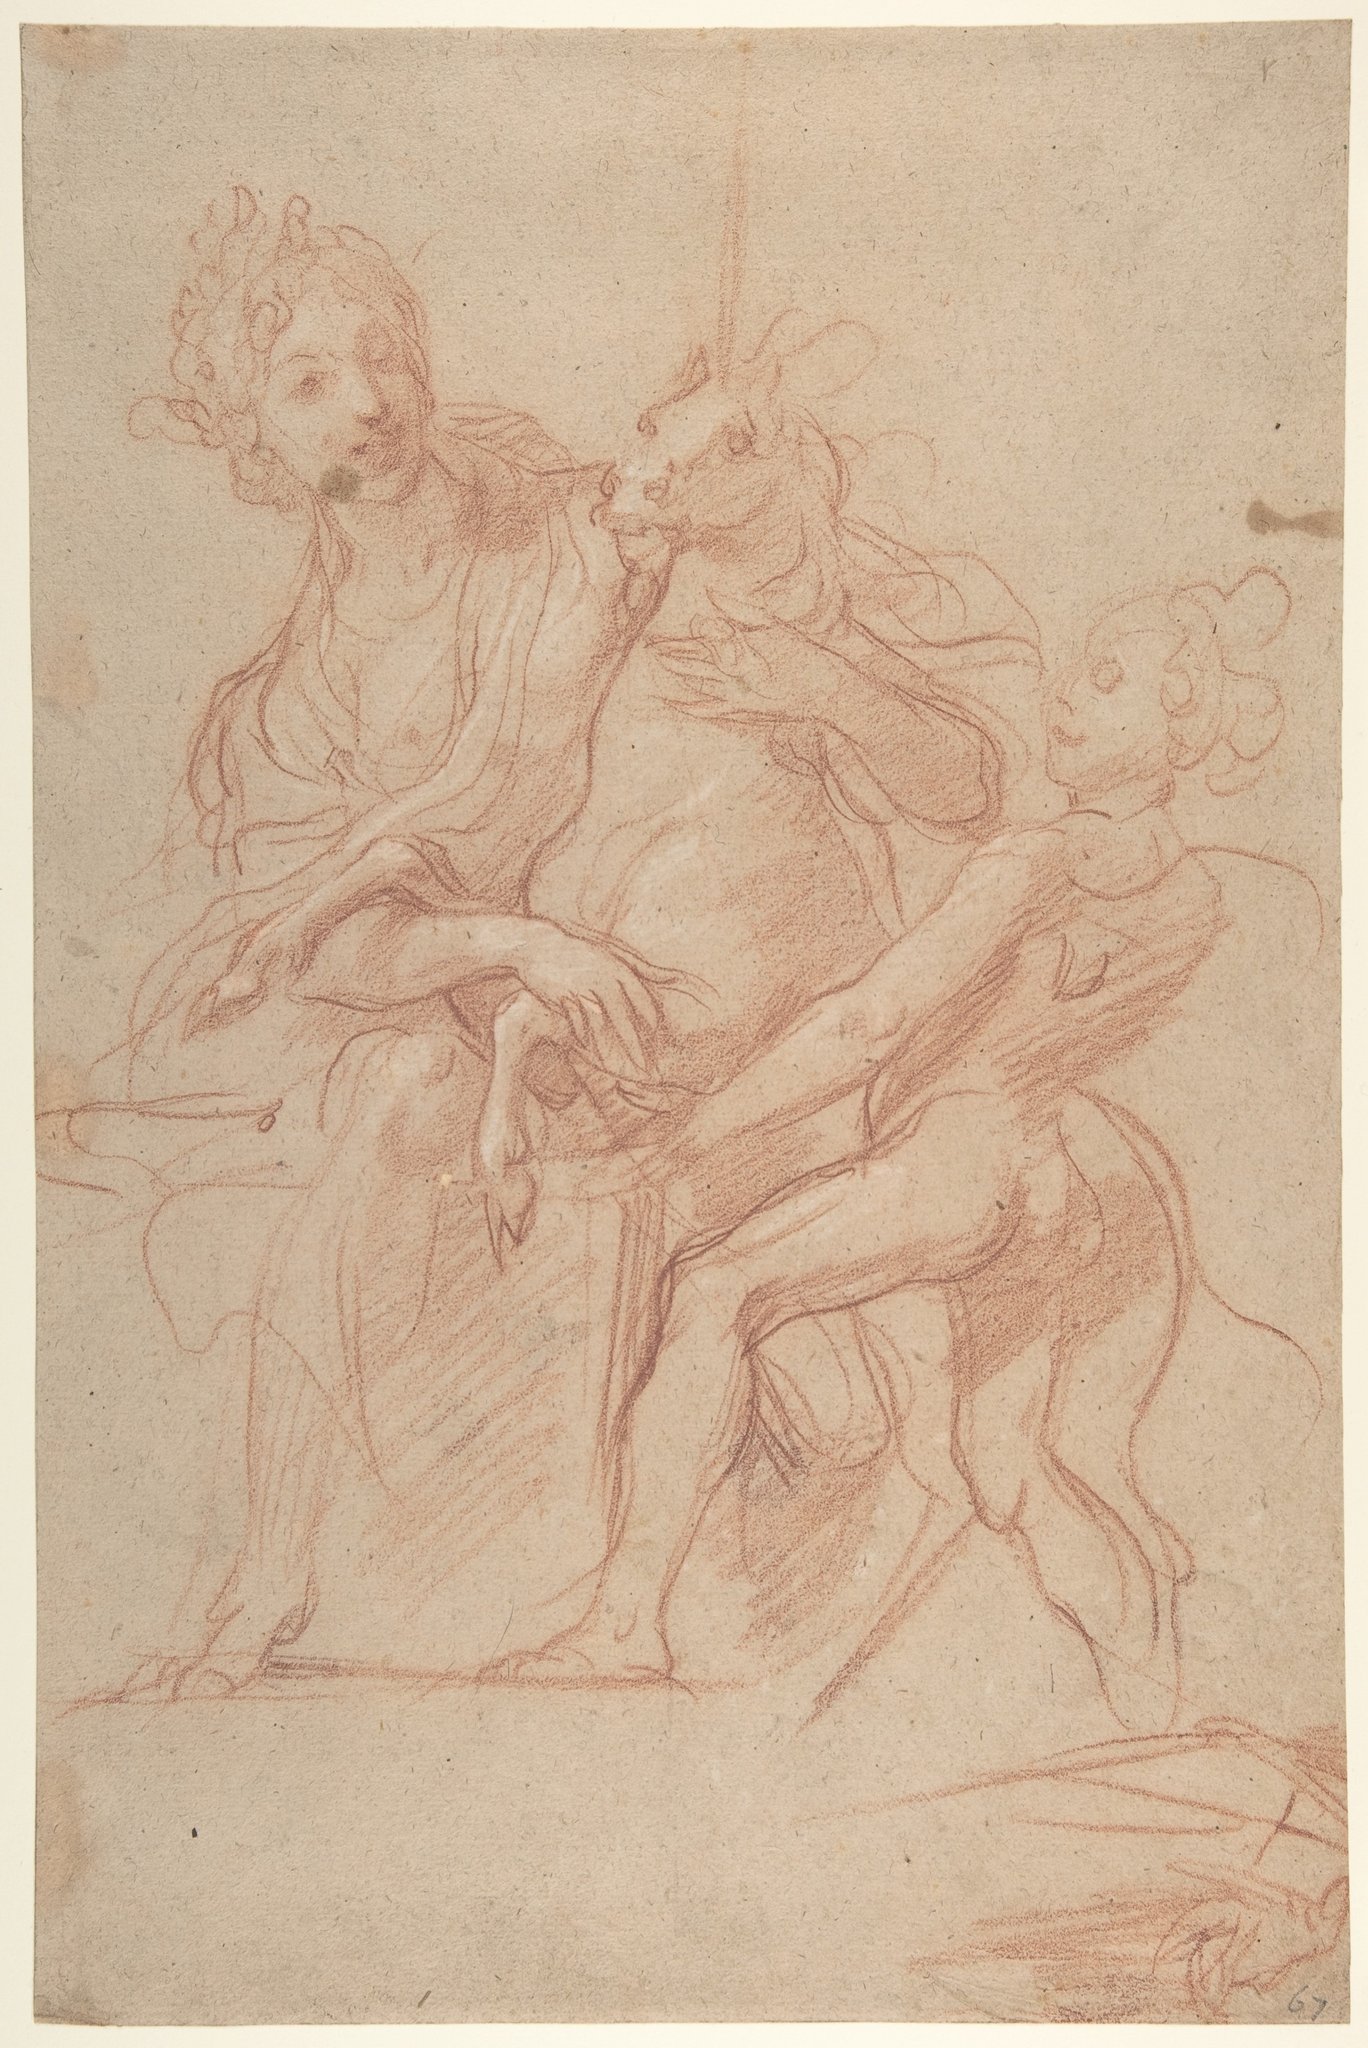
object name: drawing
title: Allegorical Figure of Purity with a Unicorn and Putto (recto); Study of a Nude Boy (verso)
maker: baldassarre franceschini (il volterrano)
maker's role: artist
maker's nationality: italian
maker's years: 1611-1690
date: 1642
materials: chalk, paper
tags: boys,women,unicorns